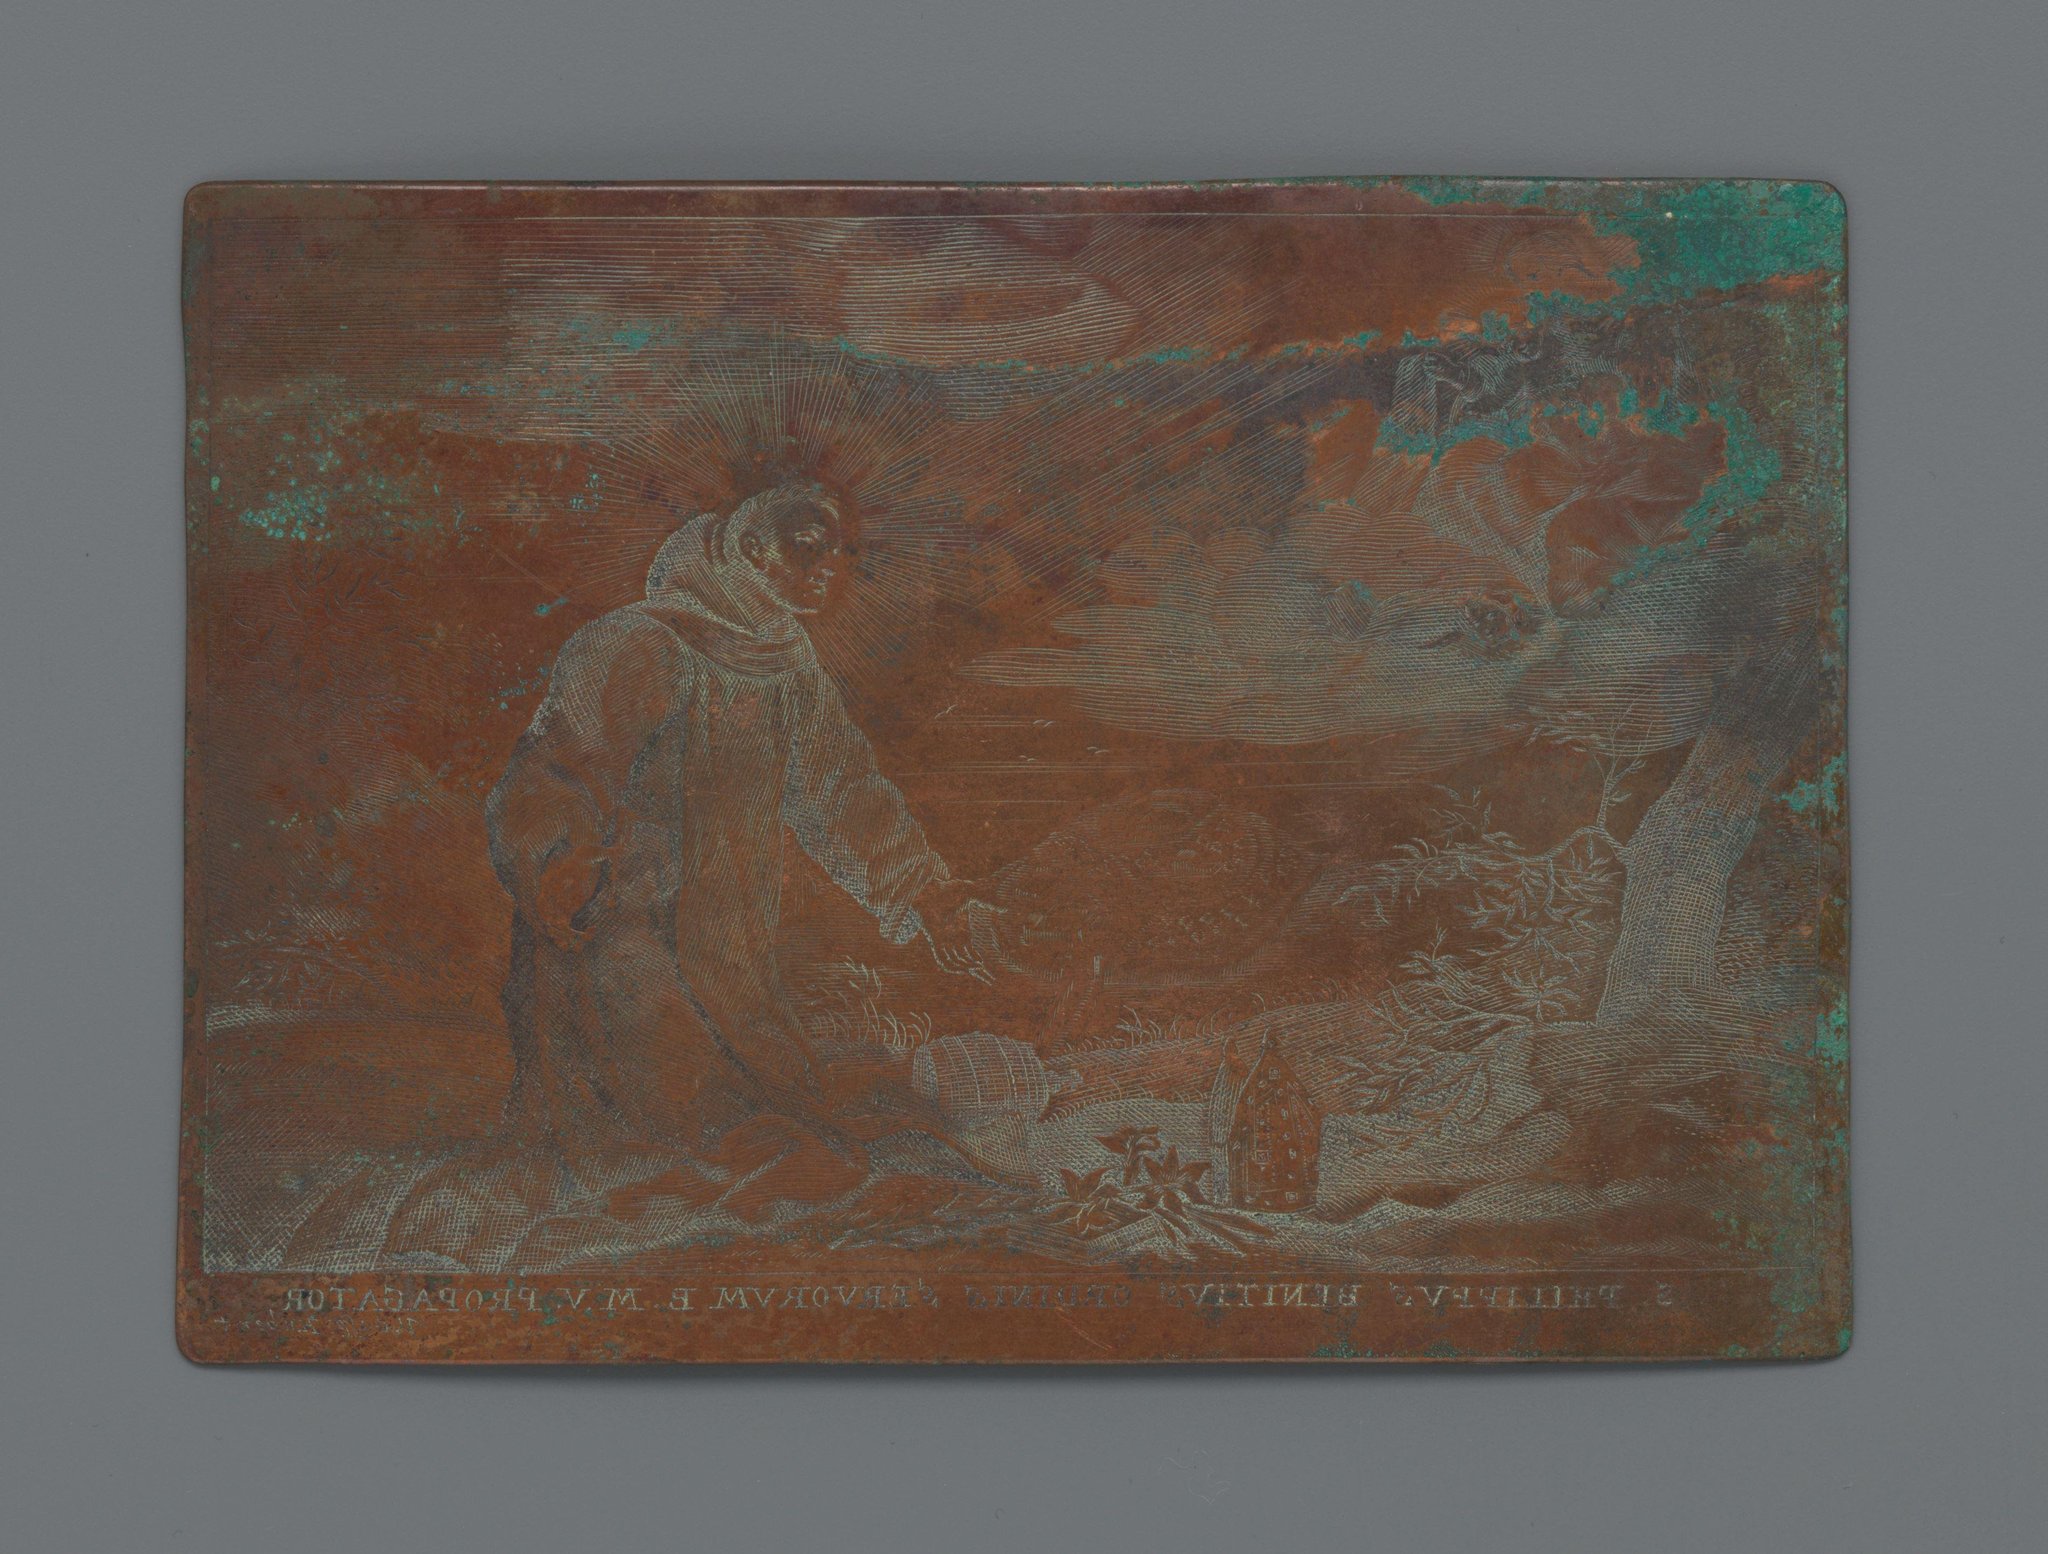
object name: copper plate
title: Koperplaat met de Heilige Filippo Neri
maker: gaspar huybrechts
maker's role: print maker, publisher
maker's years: 1619-1684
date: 1629-1684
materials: copper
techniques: engraving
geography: antwerp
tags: the madonna appears to st. philip neri, who kneels down in prayer, or celebrates mass; sometimes two angels support the swooning philip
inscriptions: : ‘S Philippus benitius ordinis servorum B.M.V. Propagator’, signature: ‘V. Gasp. Huberti’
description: De platen (RP-D-2014-9-1 t/m 35) zijn vrijwel allemaal vervaardigd door anonieme graveurs werkend voor de Antwerpse uitgevers Cornelis Galle, Frans Huberti (Huybrechts), Theodor van Merlen II en Michel Bunel. Vermoedelijk zijn ze uiteindelijk beland in één fonds, wellicht dat van Michel Bunel (1670-1739) en warden sindsdien bij elkaar bewaard. Afwijkend is de grote prent van Henry Verbruggen met een weergave van de Preekstoel uit de St. Gudule-kerk te Brussel. Twee prenten zijn verpakt in een oude afdruk van de prent, zoals te doen gebruikelijk in uitgeverijen (vergl. oude platen in Museum Plantijn Moretus, Antwerpen). Van 8 platen heeft de vorige eigenaar afdrukken laten maken op modern papier.